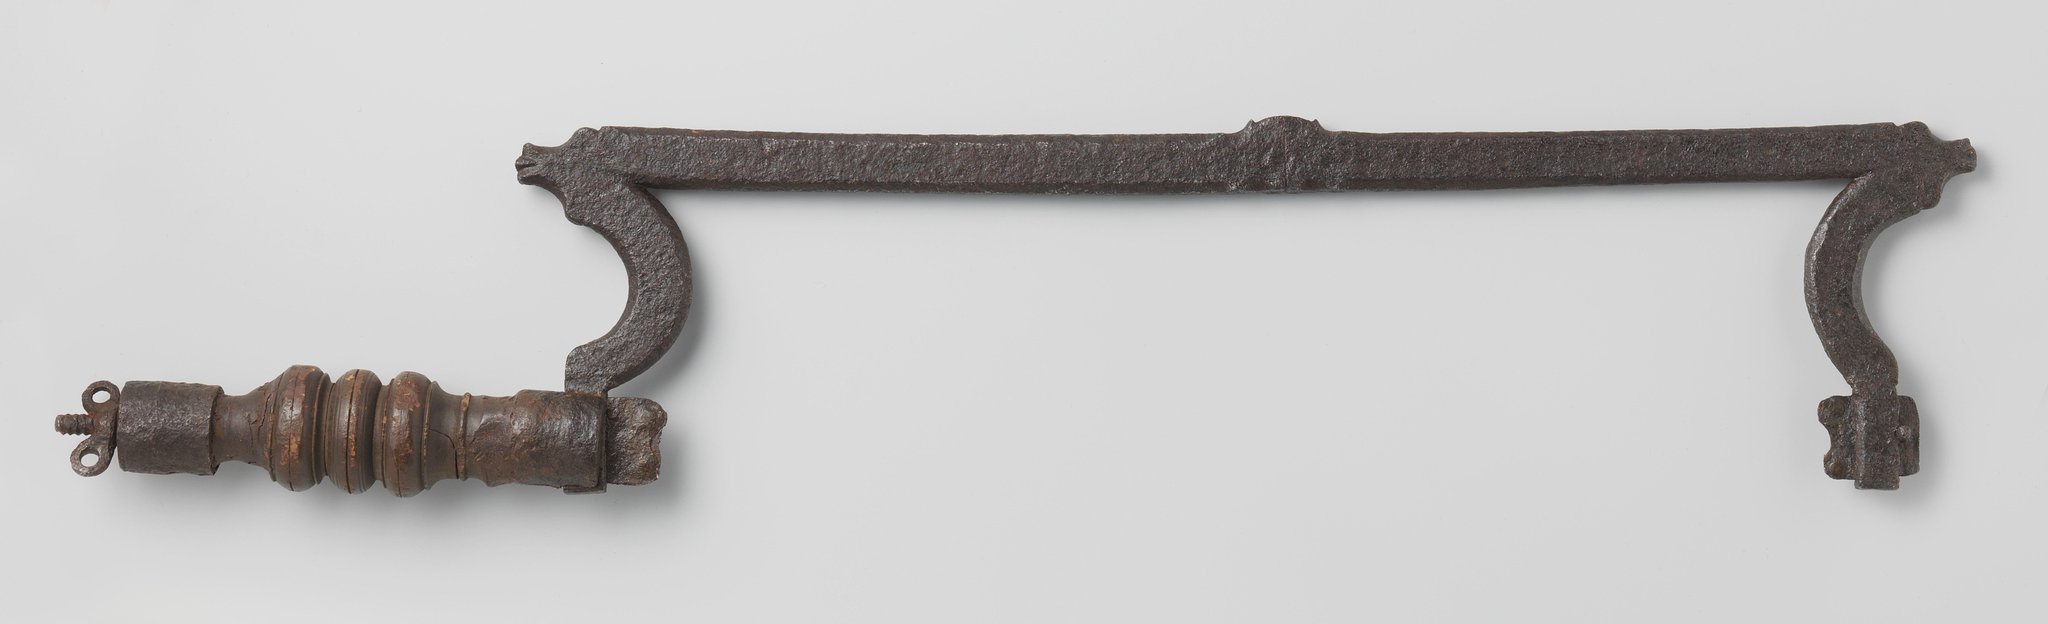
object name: frame saw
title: Tools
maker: Anonymous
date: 1590-1596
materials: iron, wood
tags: willem barendsz., amsterdam, jacob van heemskerck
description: Most of the implements found on Nova Zembla are carpentry and shipbuilding tools. The (surgeon’s) saw is the exception and was probably used to perform amputations.